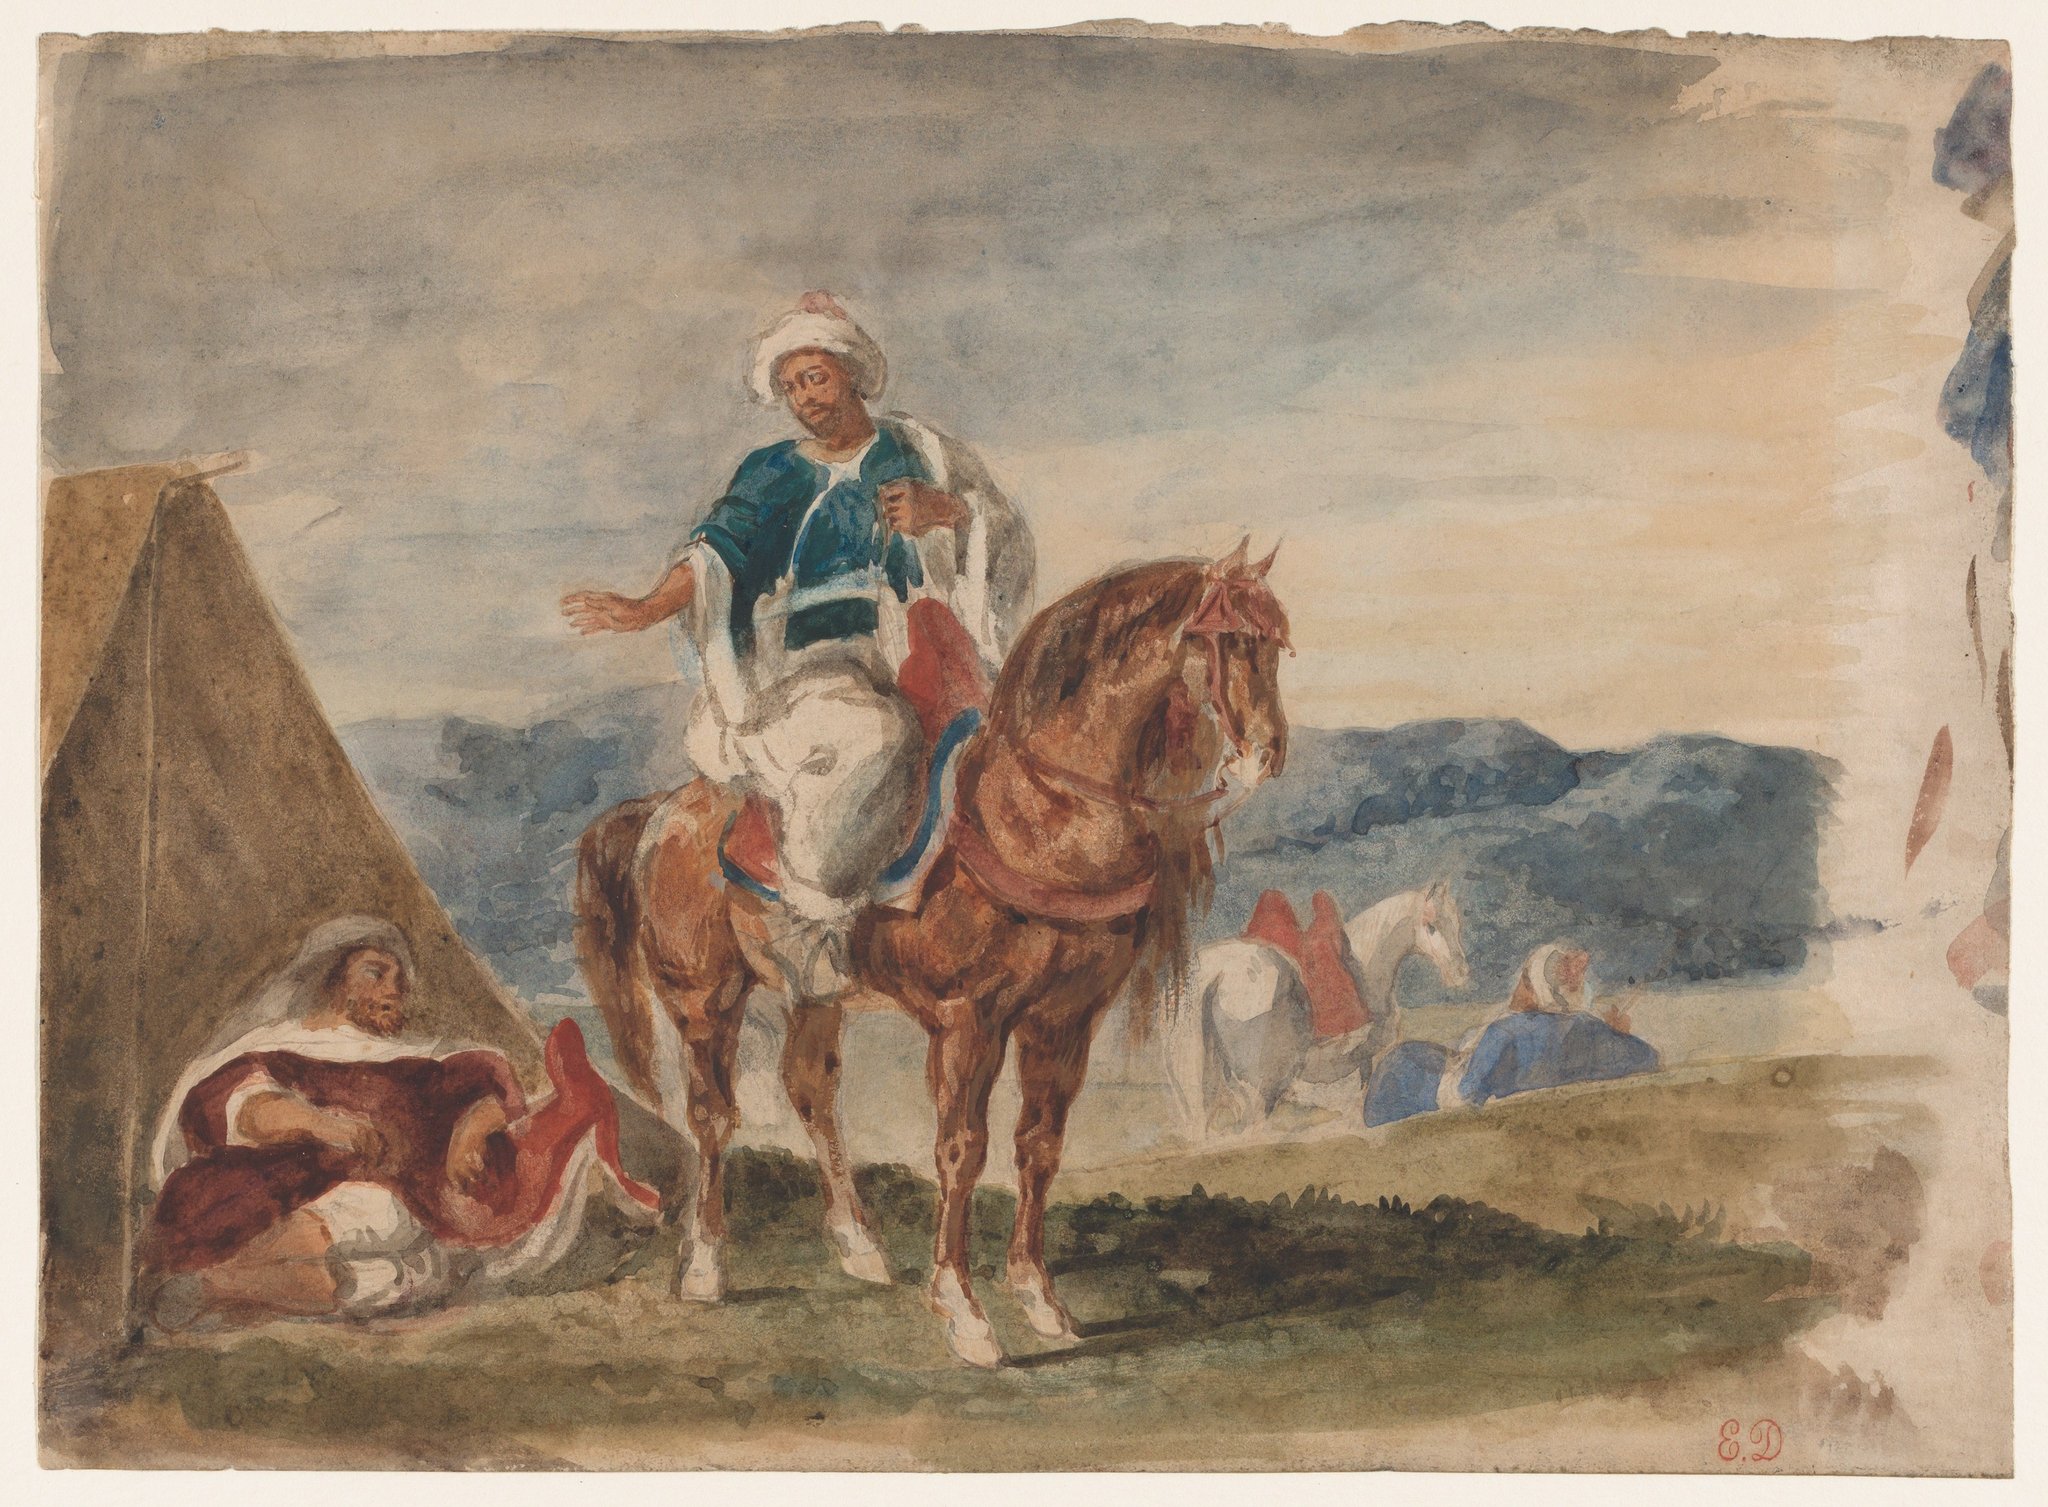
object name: drawing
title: Three Arab Horsemen at an Encampment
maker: eugène delacroix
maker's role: artist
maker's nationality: french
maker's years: 1798-1863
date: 1832-1837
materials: graphite, watercolor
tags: tents,men,horses